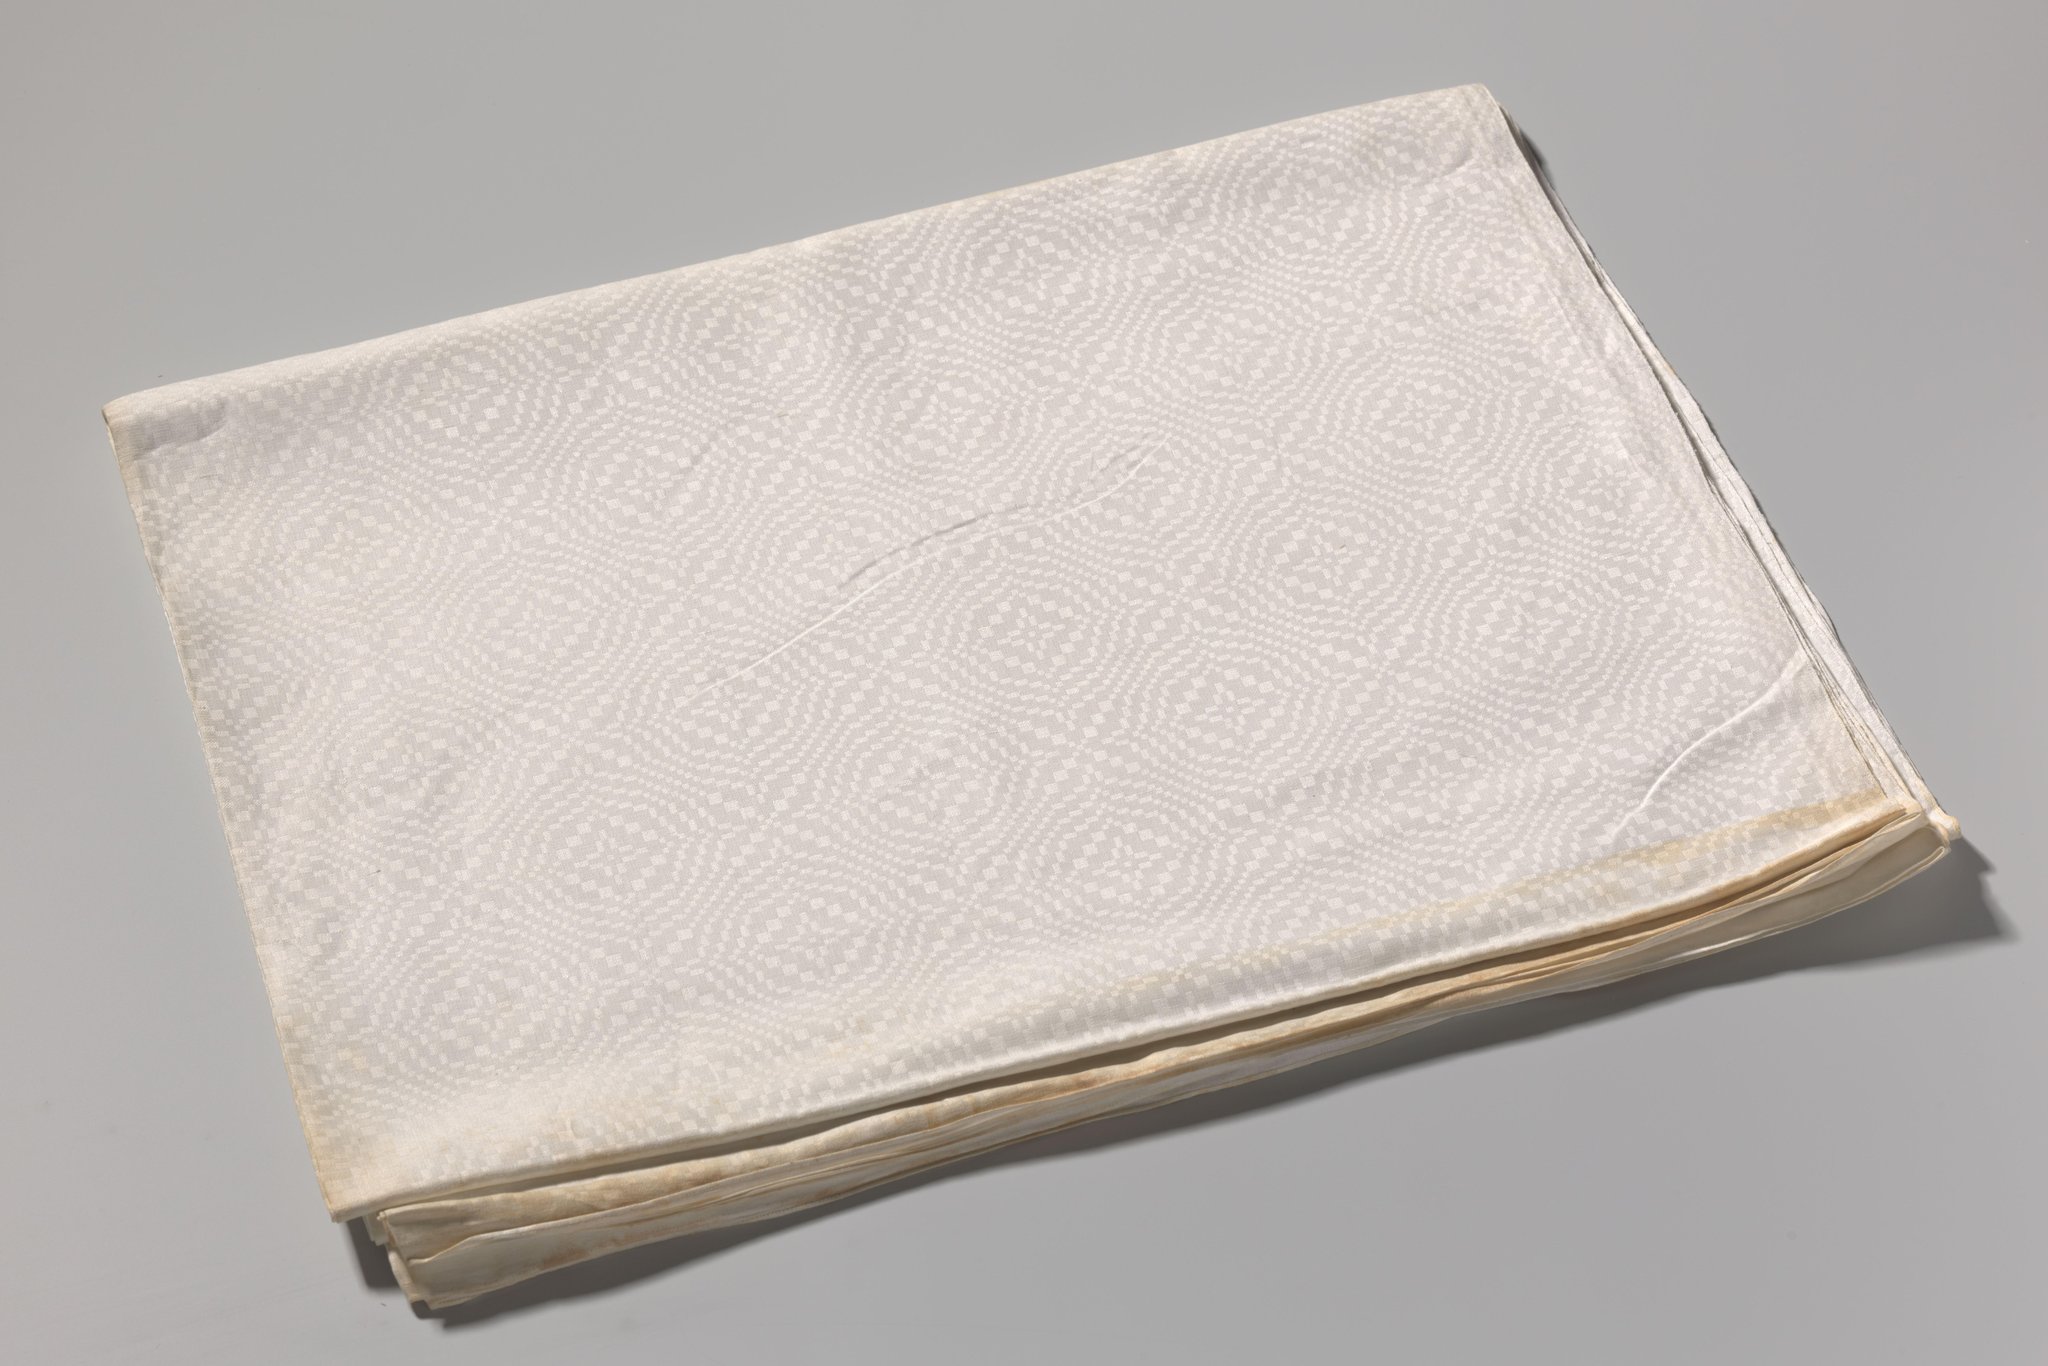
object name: tablecloth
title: Pellen, patroon 'fijne molenwiek'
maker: Anonymous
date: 1600-1699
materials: linen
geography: northern netherlands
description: Tafellaken van wit linnen met een pellenpatroon z.g. 'fijne molenwiek'.